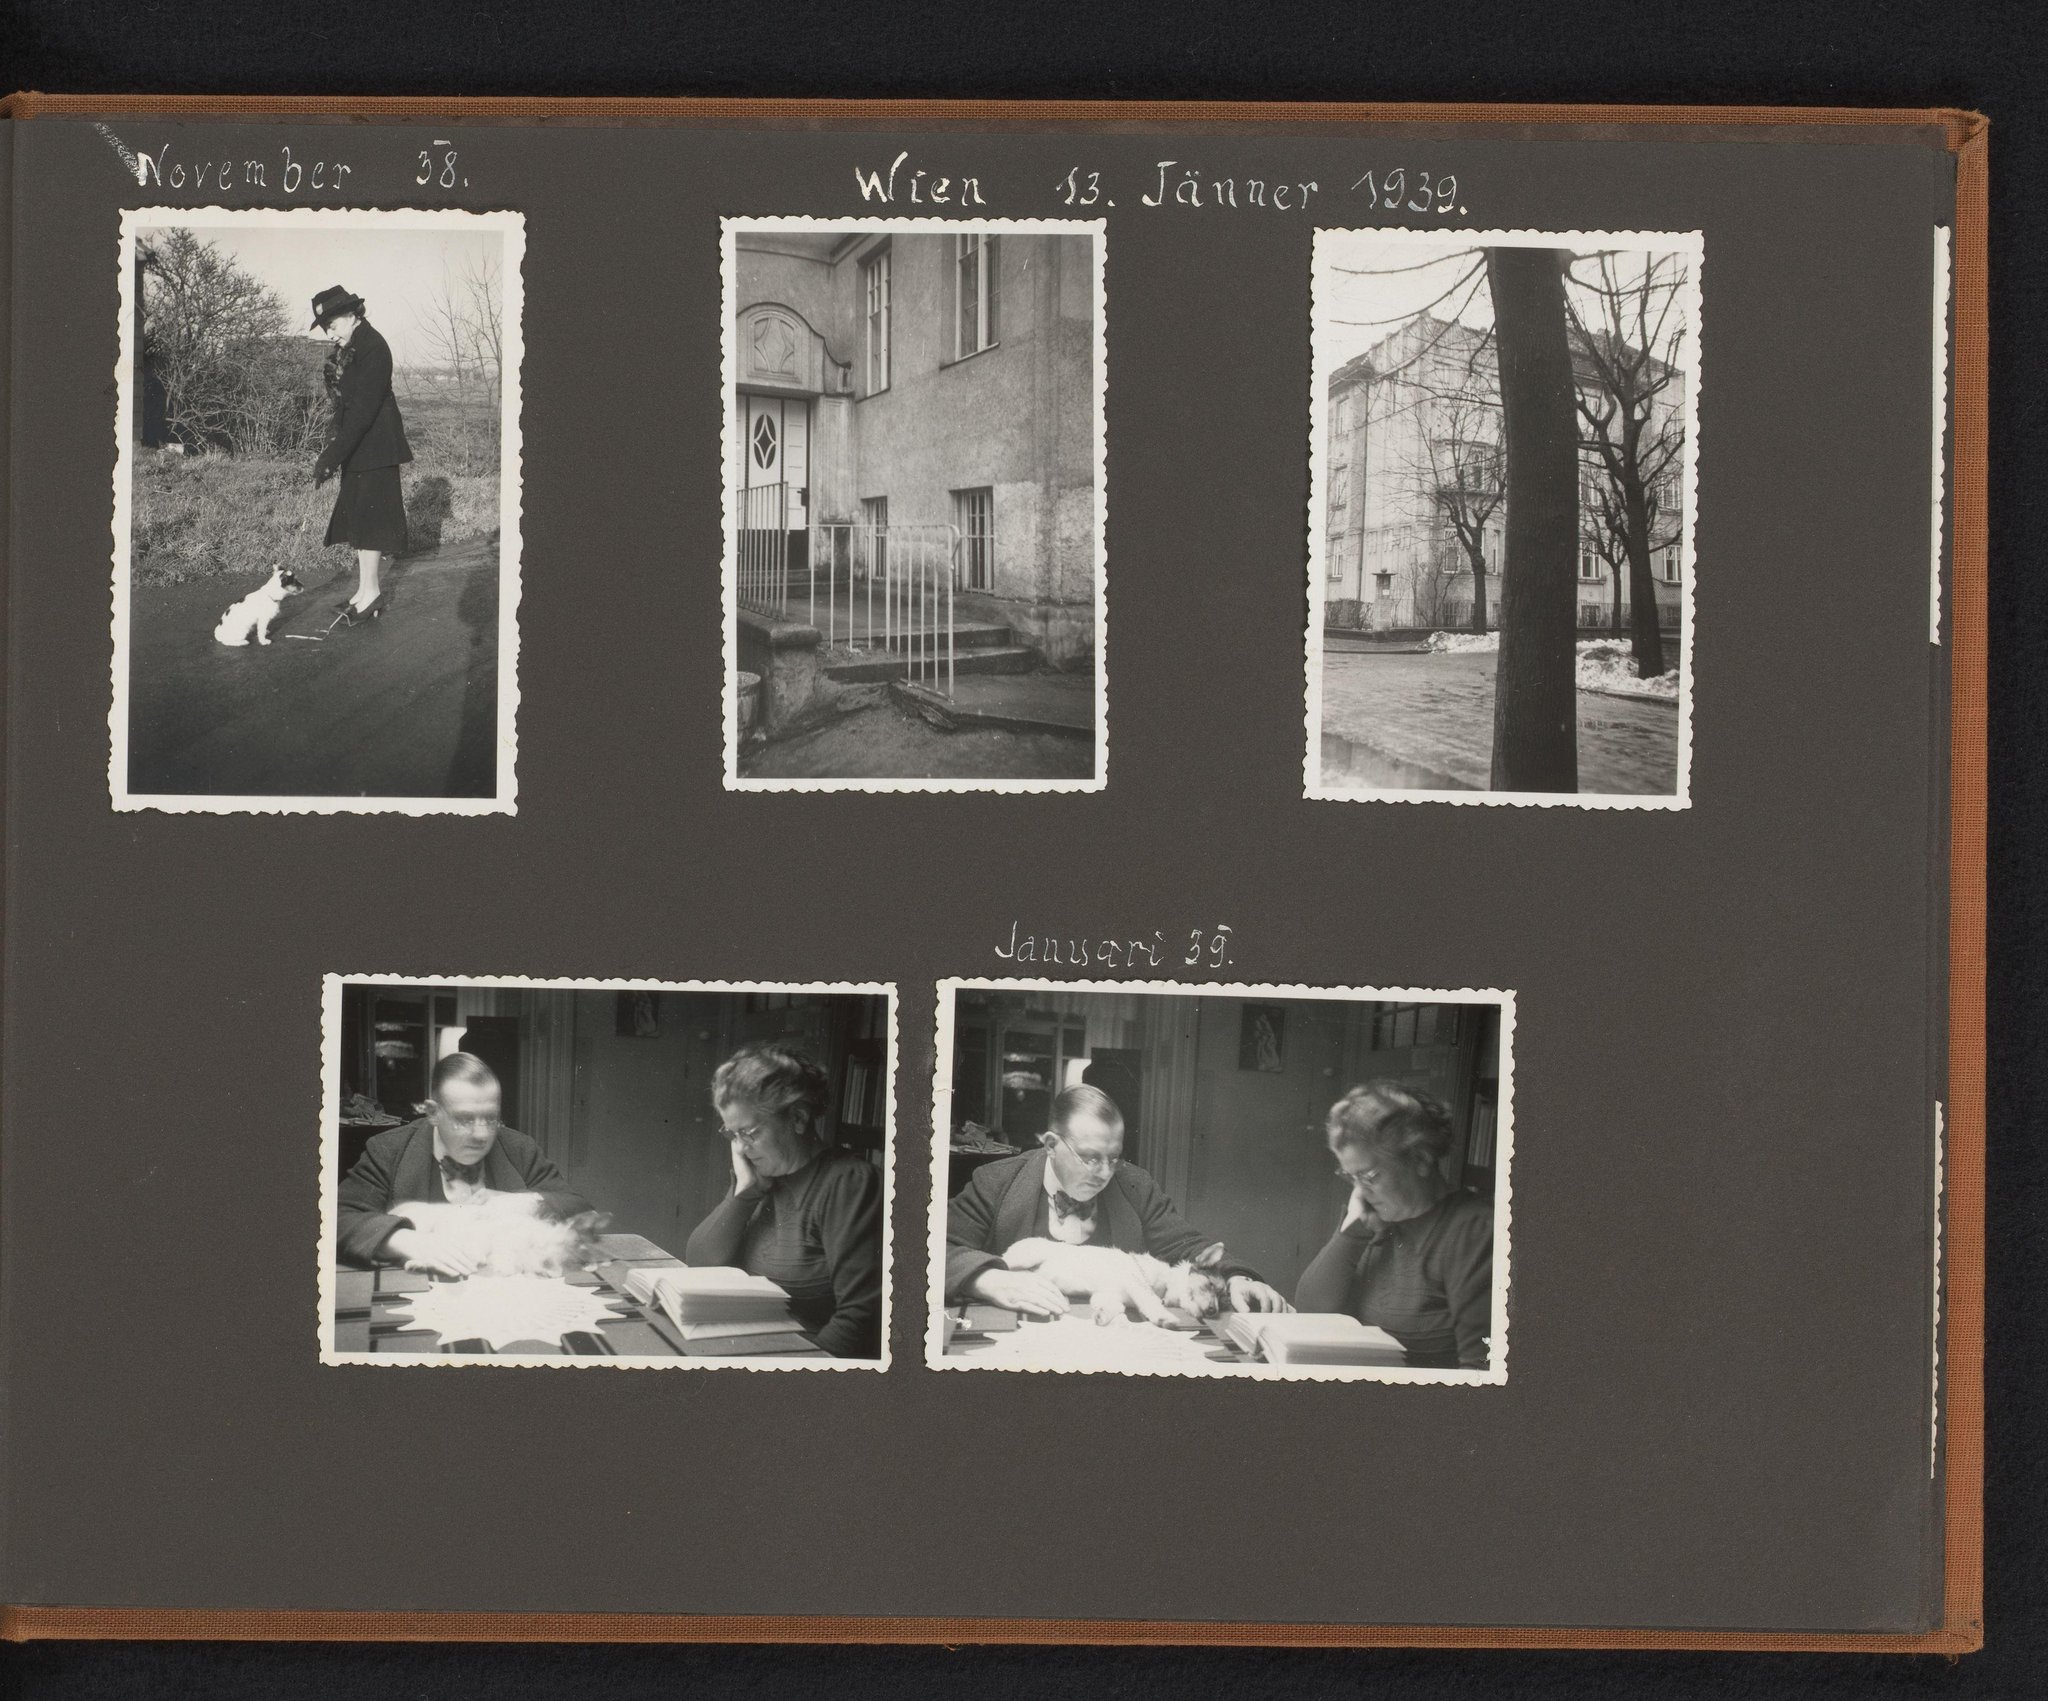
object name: photograph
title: Berti Hoppe met Bessie en een bezoek aan Wenen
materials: cardboard, paper, photographic support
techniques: gelatin silver print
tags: berti hoppe, historical persons, walking the dog, interior of the house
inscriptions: date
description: Vijf foto's uit het leven van Berti Hoppe en Herman Besselaar. Onder andere met de hond Bessie en van het bezoek aan de ouders van Berti Hoppe in Wenen. Deze pagina maakt deel uit van een album.